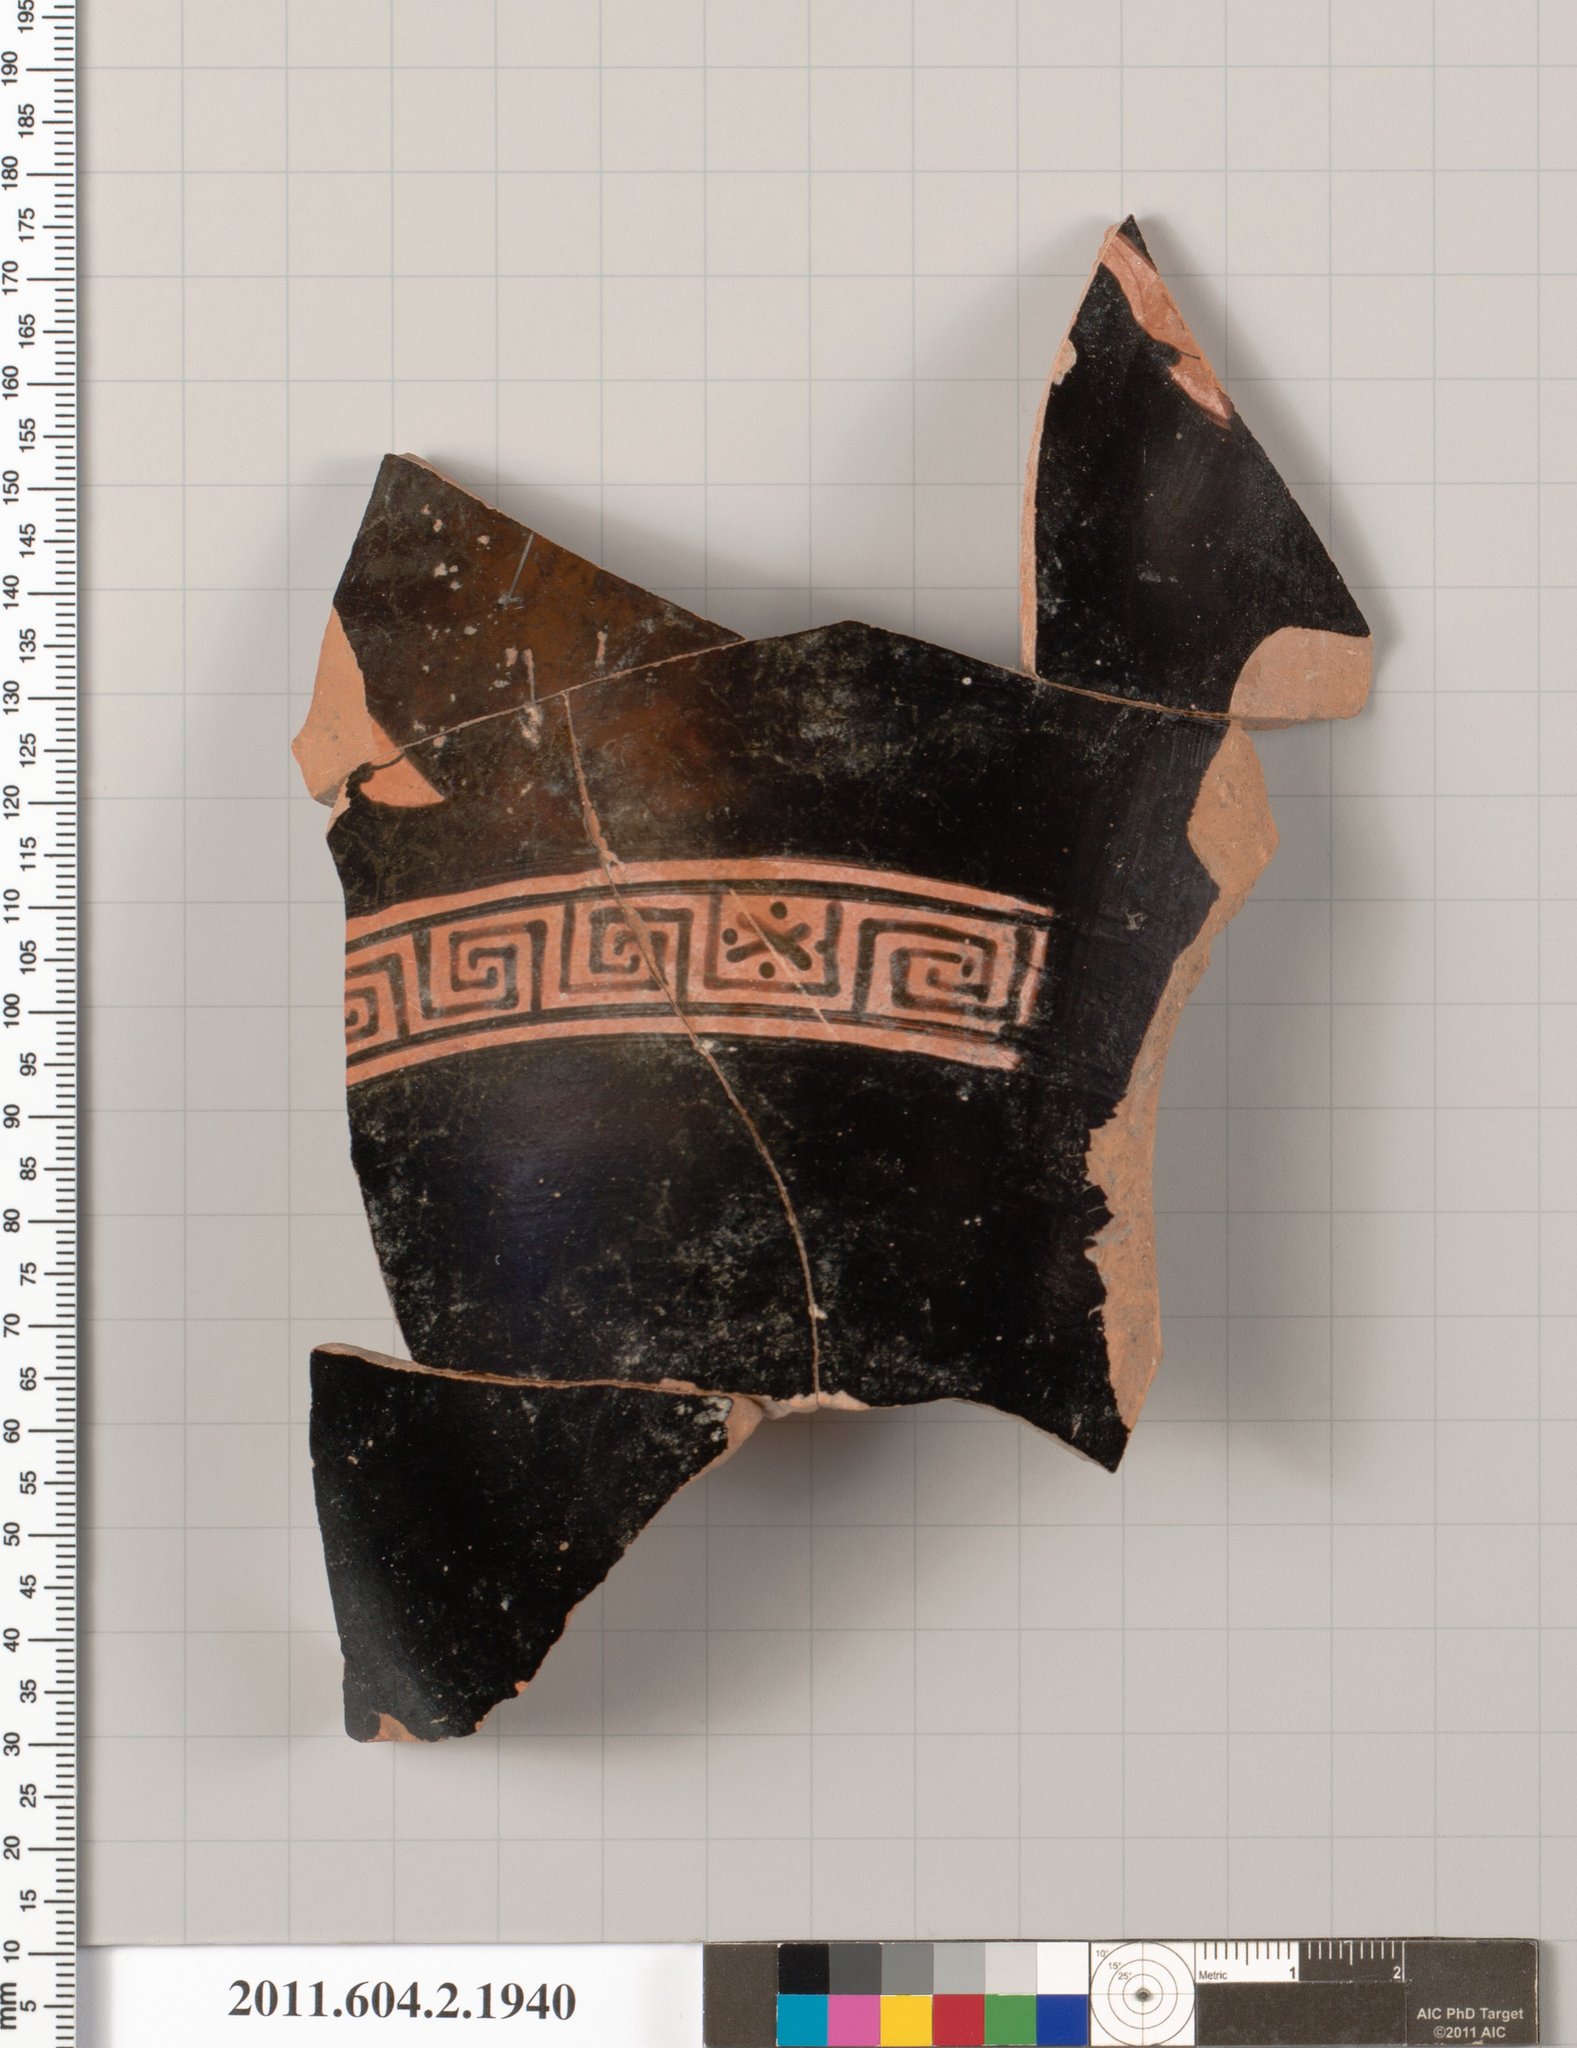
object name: neck amphora fragment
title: Terracotta fragment of a Nolan neck-amphora (jar)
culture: greek, attic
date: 475-460 BCE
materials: terracotta